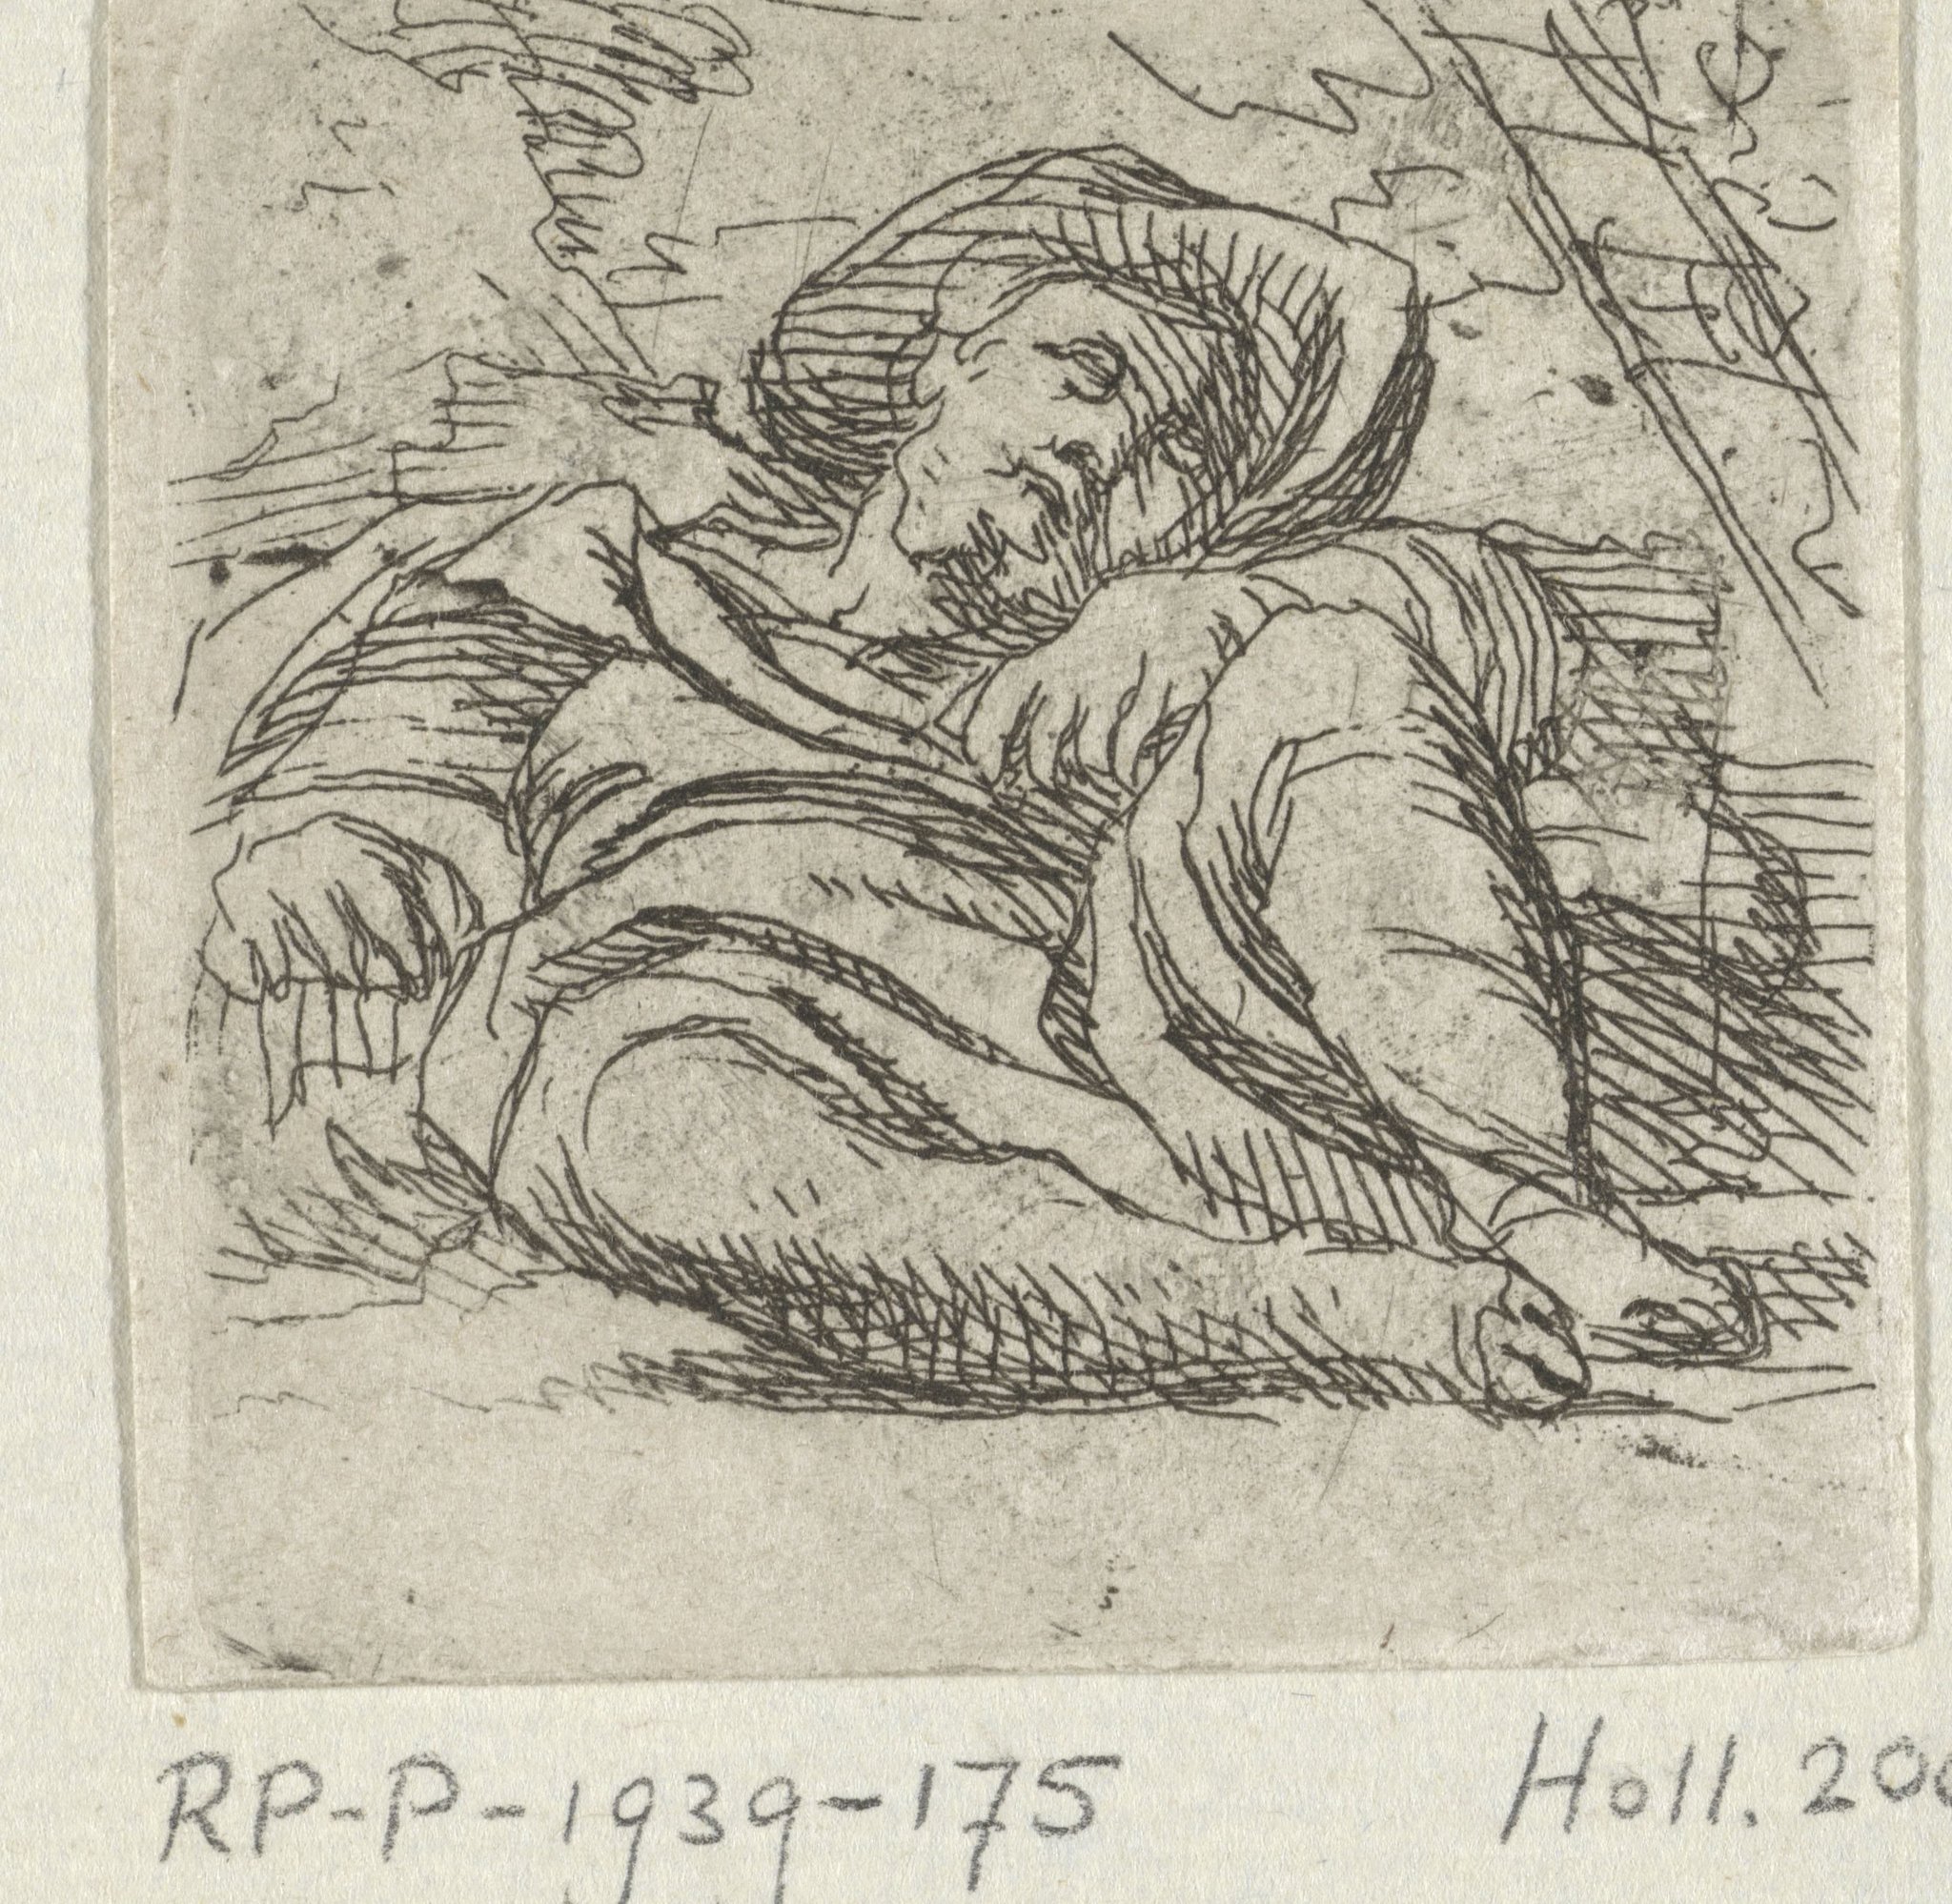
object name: print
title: Slapende man met hoed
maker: cornelis schut (i)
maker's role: draughtsman, print maker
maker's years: 1597-1655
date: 1618-1655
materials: paper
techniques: etching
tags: sleeping; unconsciousness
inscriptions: collector's mark: Lugt 2228